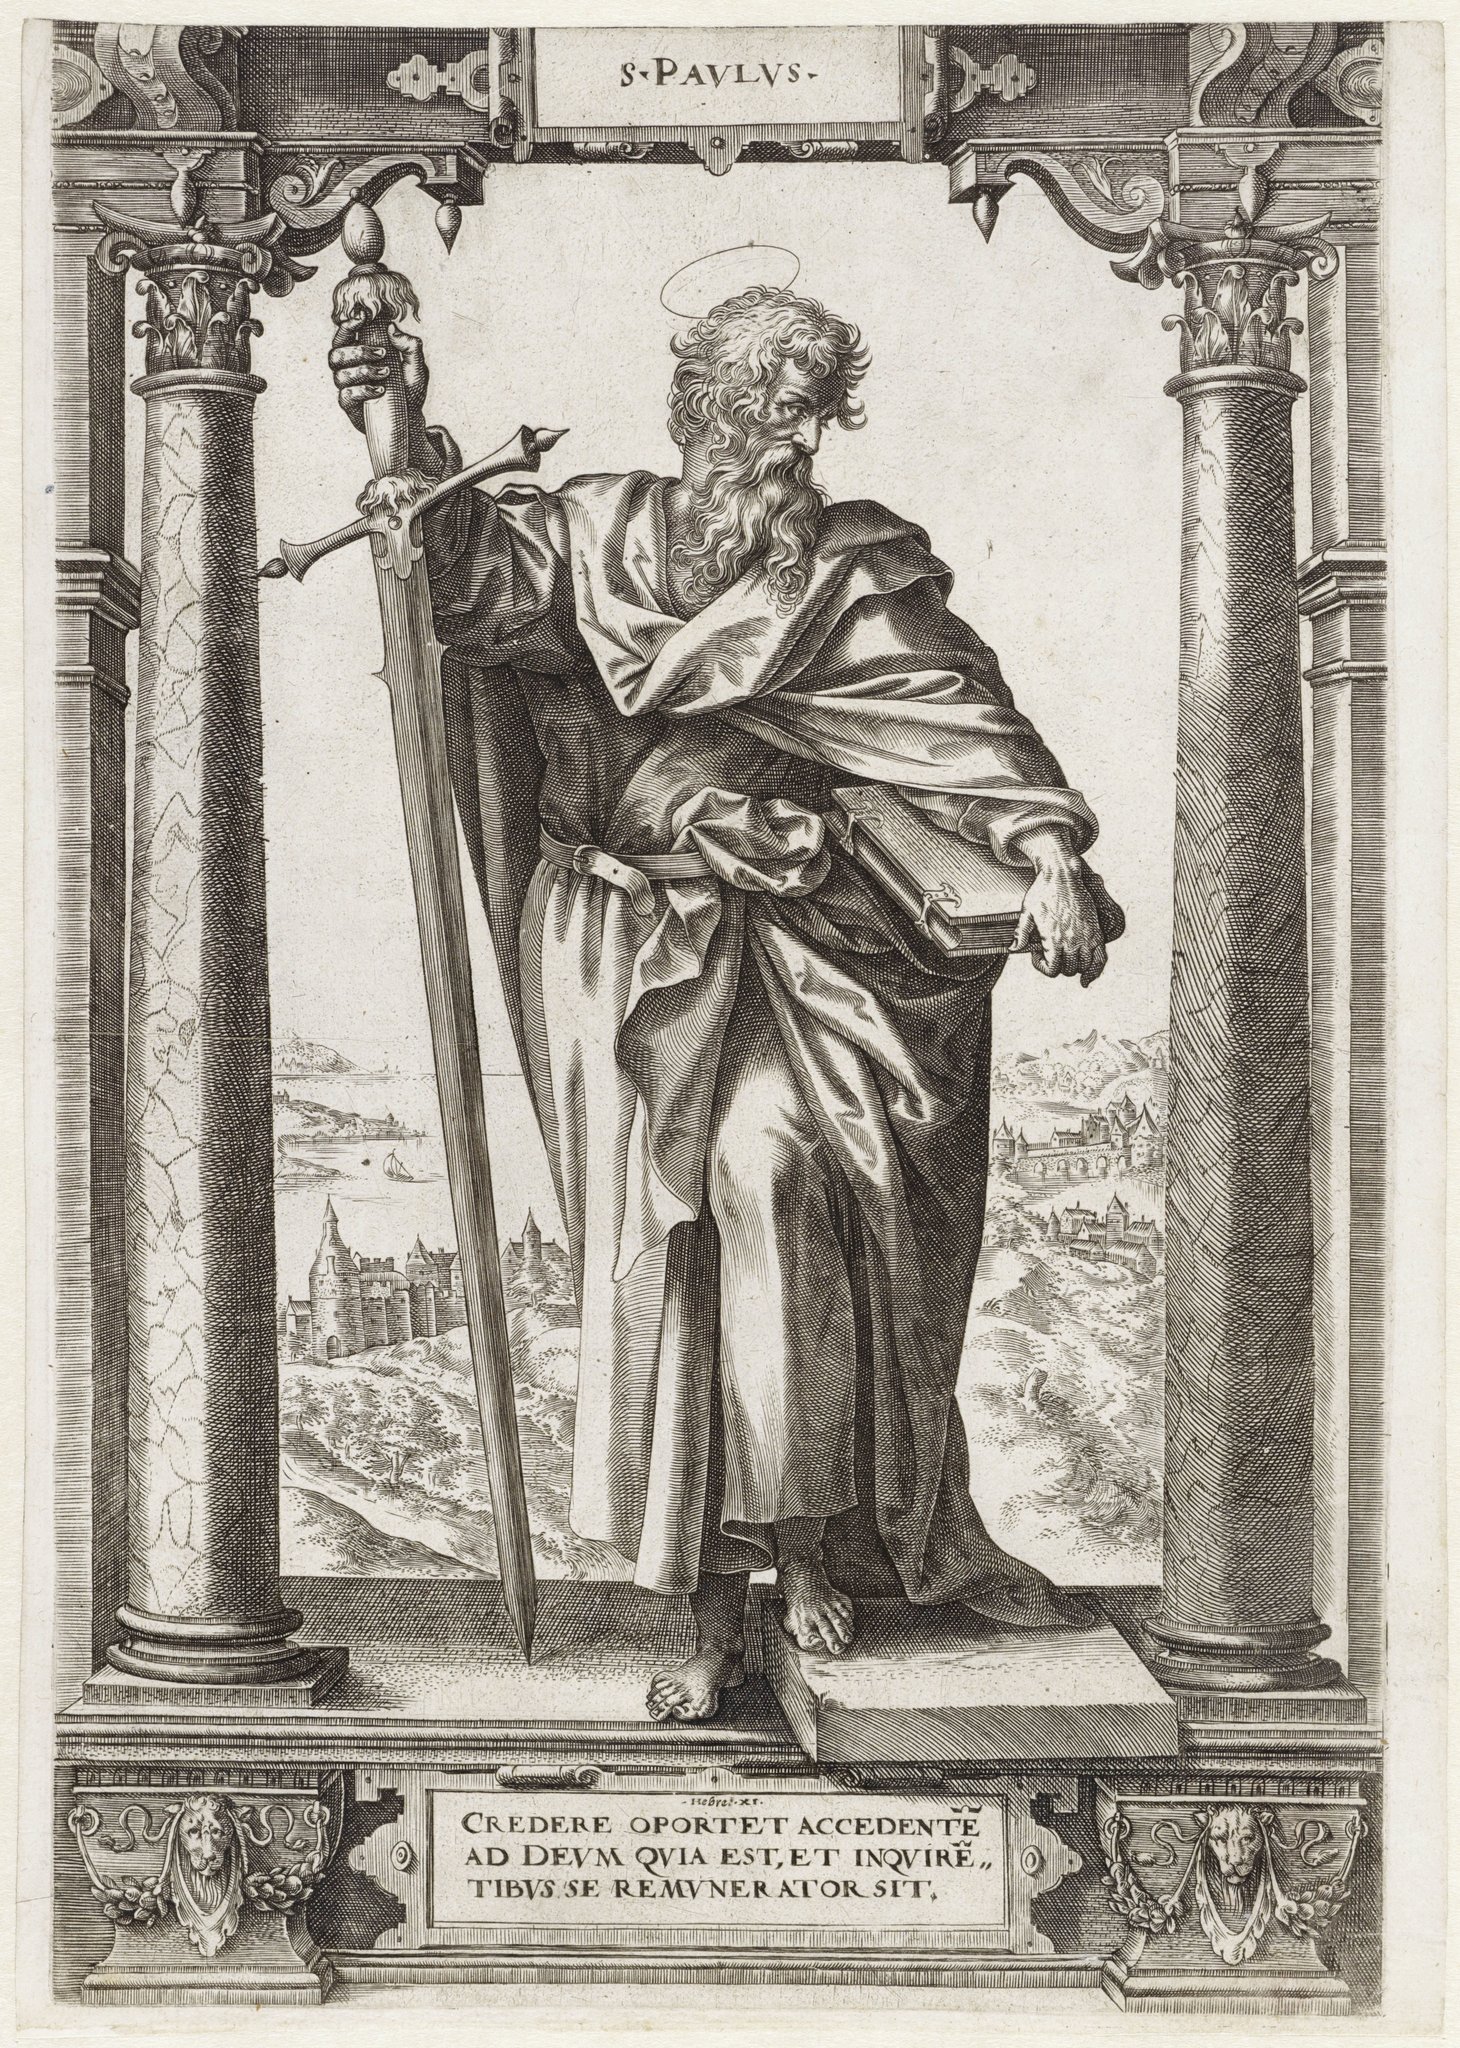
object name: print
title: H. Paulus van Tarsus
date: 1578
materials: paper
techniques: engraving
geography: antwerp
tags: column, pillar ~ architecture, the apostle paul of tarsus; possible attributes: book, scroll, sword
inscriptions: collector's mark: Lugt 2760, collector's mark: Lugt 2228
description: De heilige Paulus van Tarsus staat, met zijn ene voet op een steen, tussen twee zuilen in een architecturale omlijsting. In zijn hand houdt hij een zwaard, onder zijn arm een boek. Op de achtergrond een gezicht op een meer en een heuvelachtig landschap. In het kader onderaan een drieregelig Bijbelcitaat uit Heb. 11 in het Latijn.